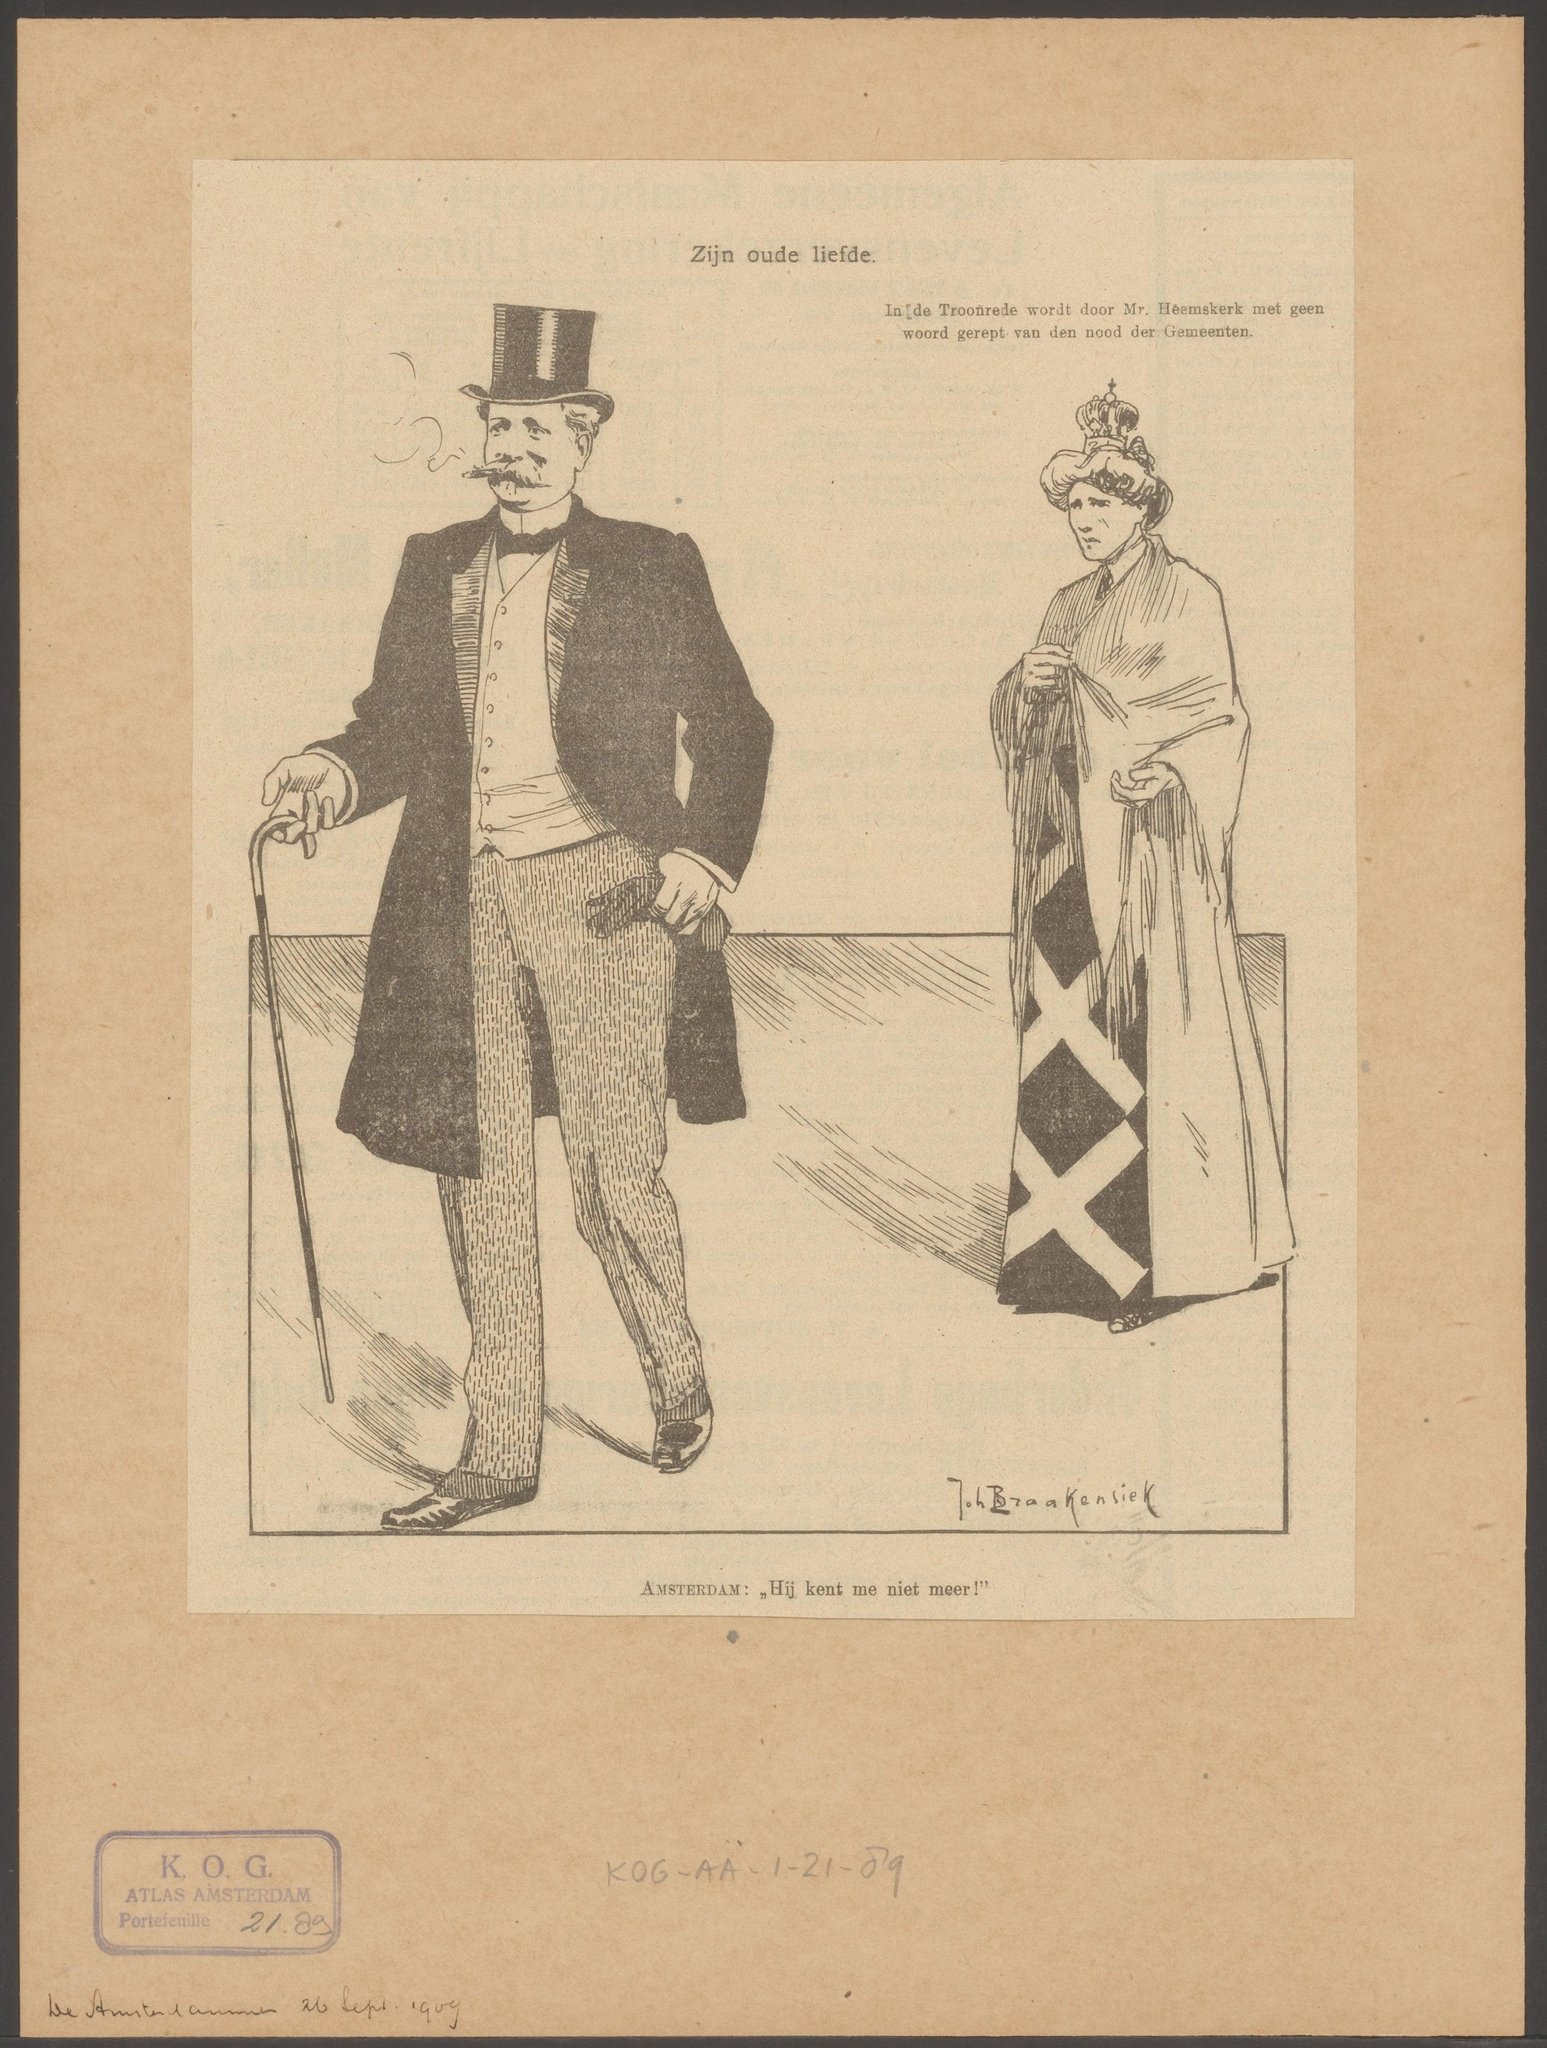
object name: cartoon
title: Man loopt weg van stedenmaagd van Amsterdam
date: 1909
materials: paper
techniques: letterpress printing, line block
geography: amsterdam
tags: personification of a city, town-patron(ess), crown (symbol of sovereignty) - bb - female ruler, political caricatures and satires, amsterdam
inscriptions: collector's mark: Lugt 1641b, inscription: ‘De Amsterdammer 26 Sept. 1909’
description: Gepubliceerd in 'De Amsterdammer' van 26 september 1909, p. 11.